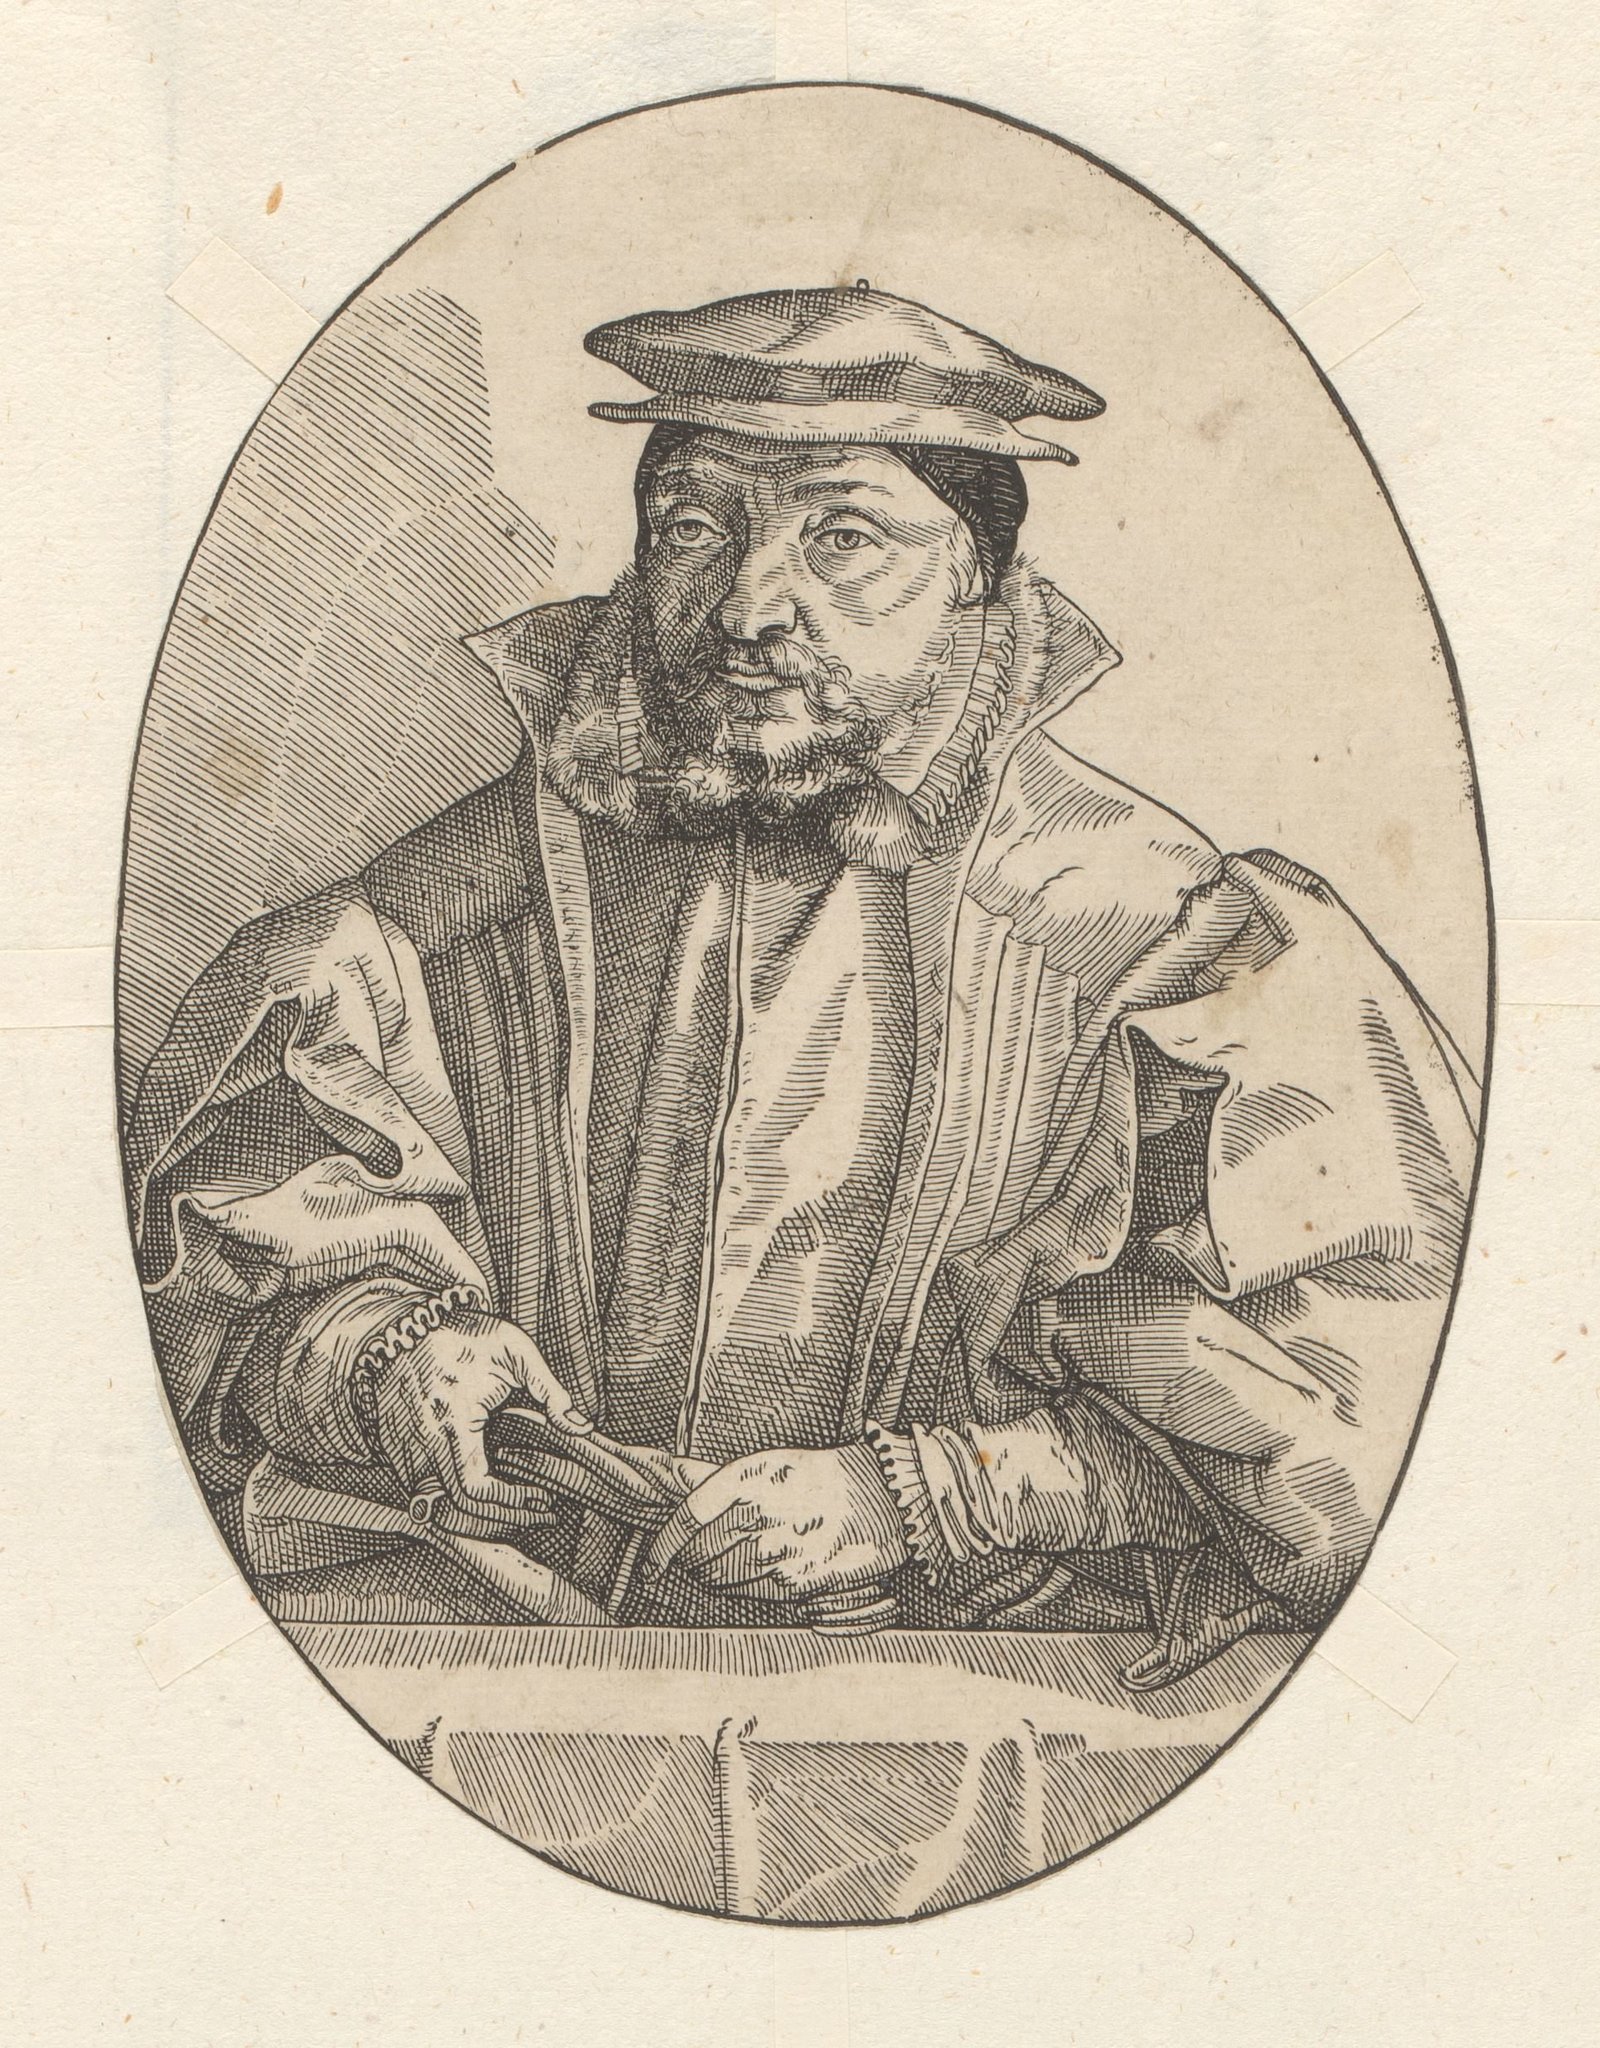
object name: print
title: Portret van Friedrich von Gottesheim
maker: Anonymous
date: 1549-1584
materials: paper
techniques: woodcut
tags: historical persons